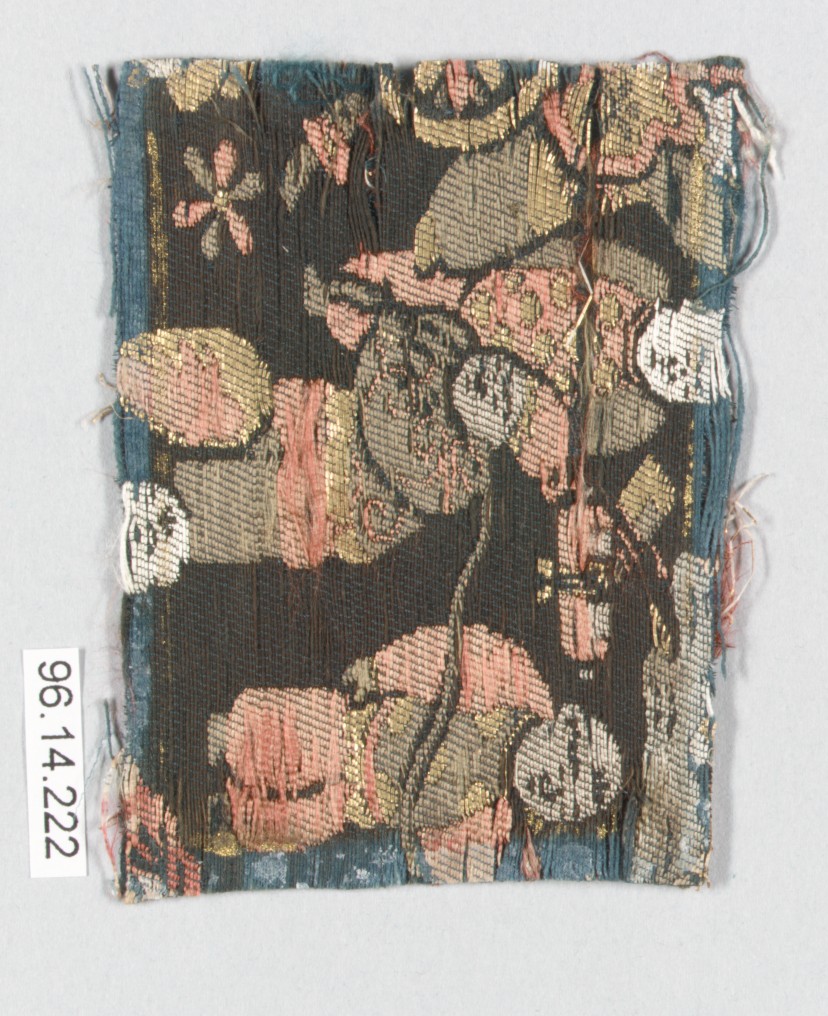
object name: piece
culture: japanese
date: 1801-1833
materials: metal thread, silk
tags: children